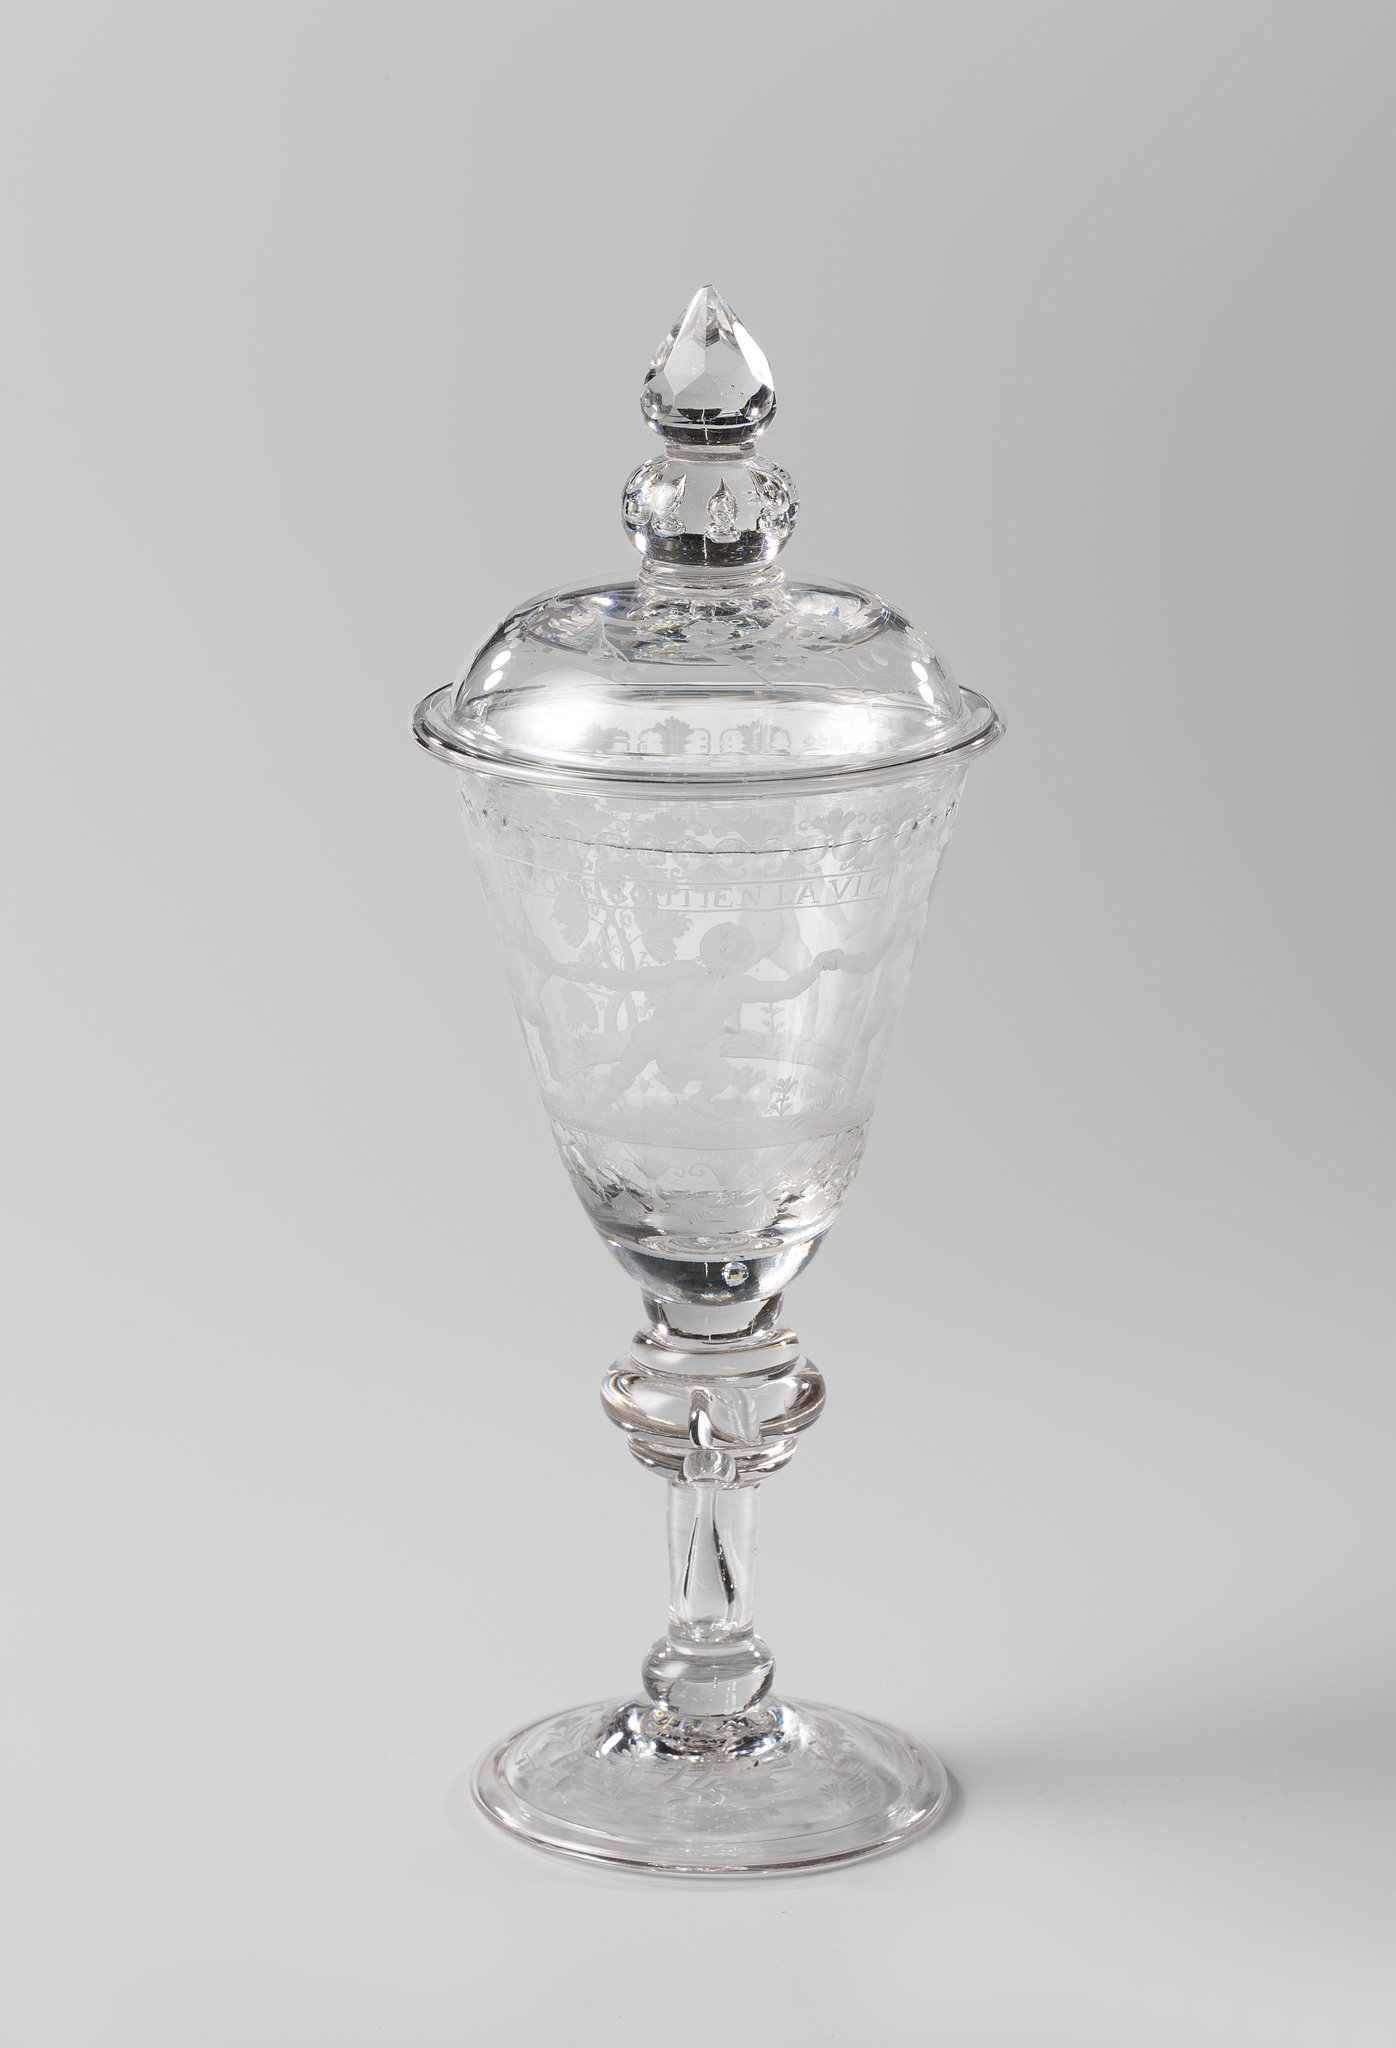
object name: goblet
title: Bokaal met Bacchus en vijf putti en LAJOYE SOUTIEN LA VIE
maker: Anonymous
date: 1710-1730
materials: glass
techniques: glassblowing, grinding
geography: schwarzburg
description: Wine glass. Wheel engraving with putti and the inscription Lajoye soutien la vie. Germany, c. 1710 - 1730. A.J. Enschedé bequest, 1896.